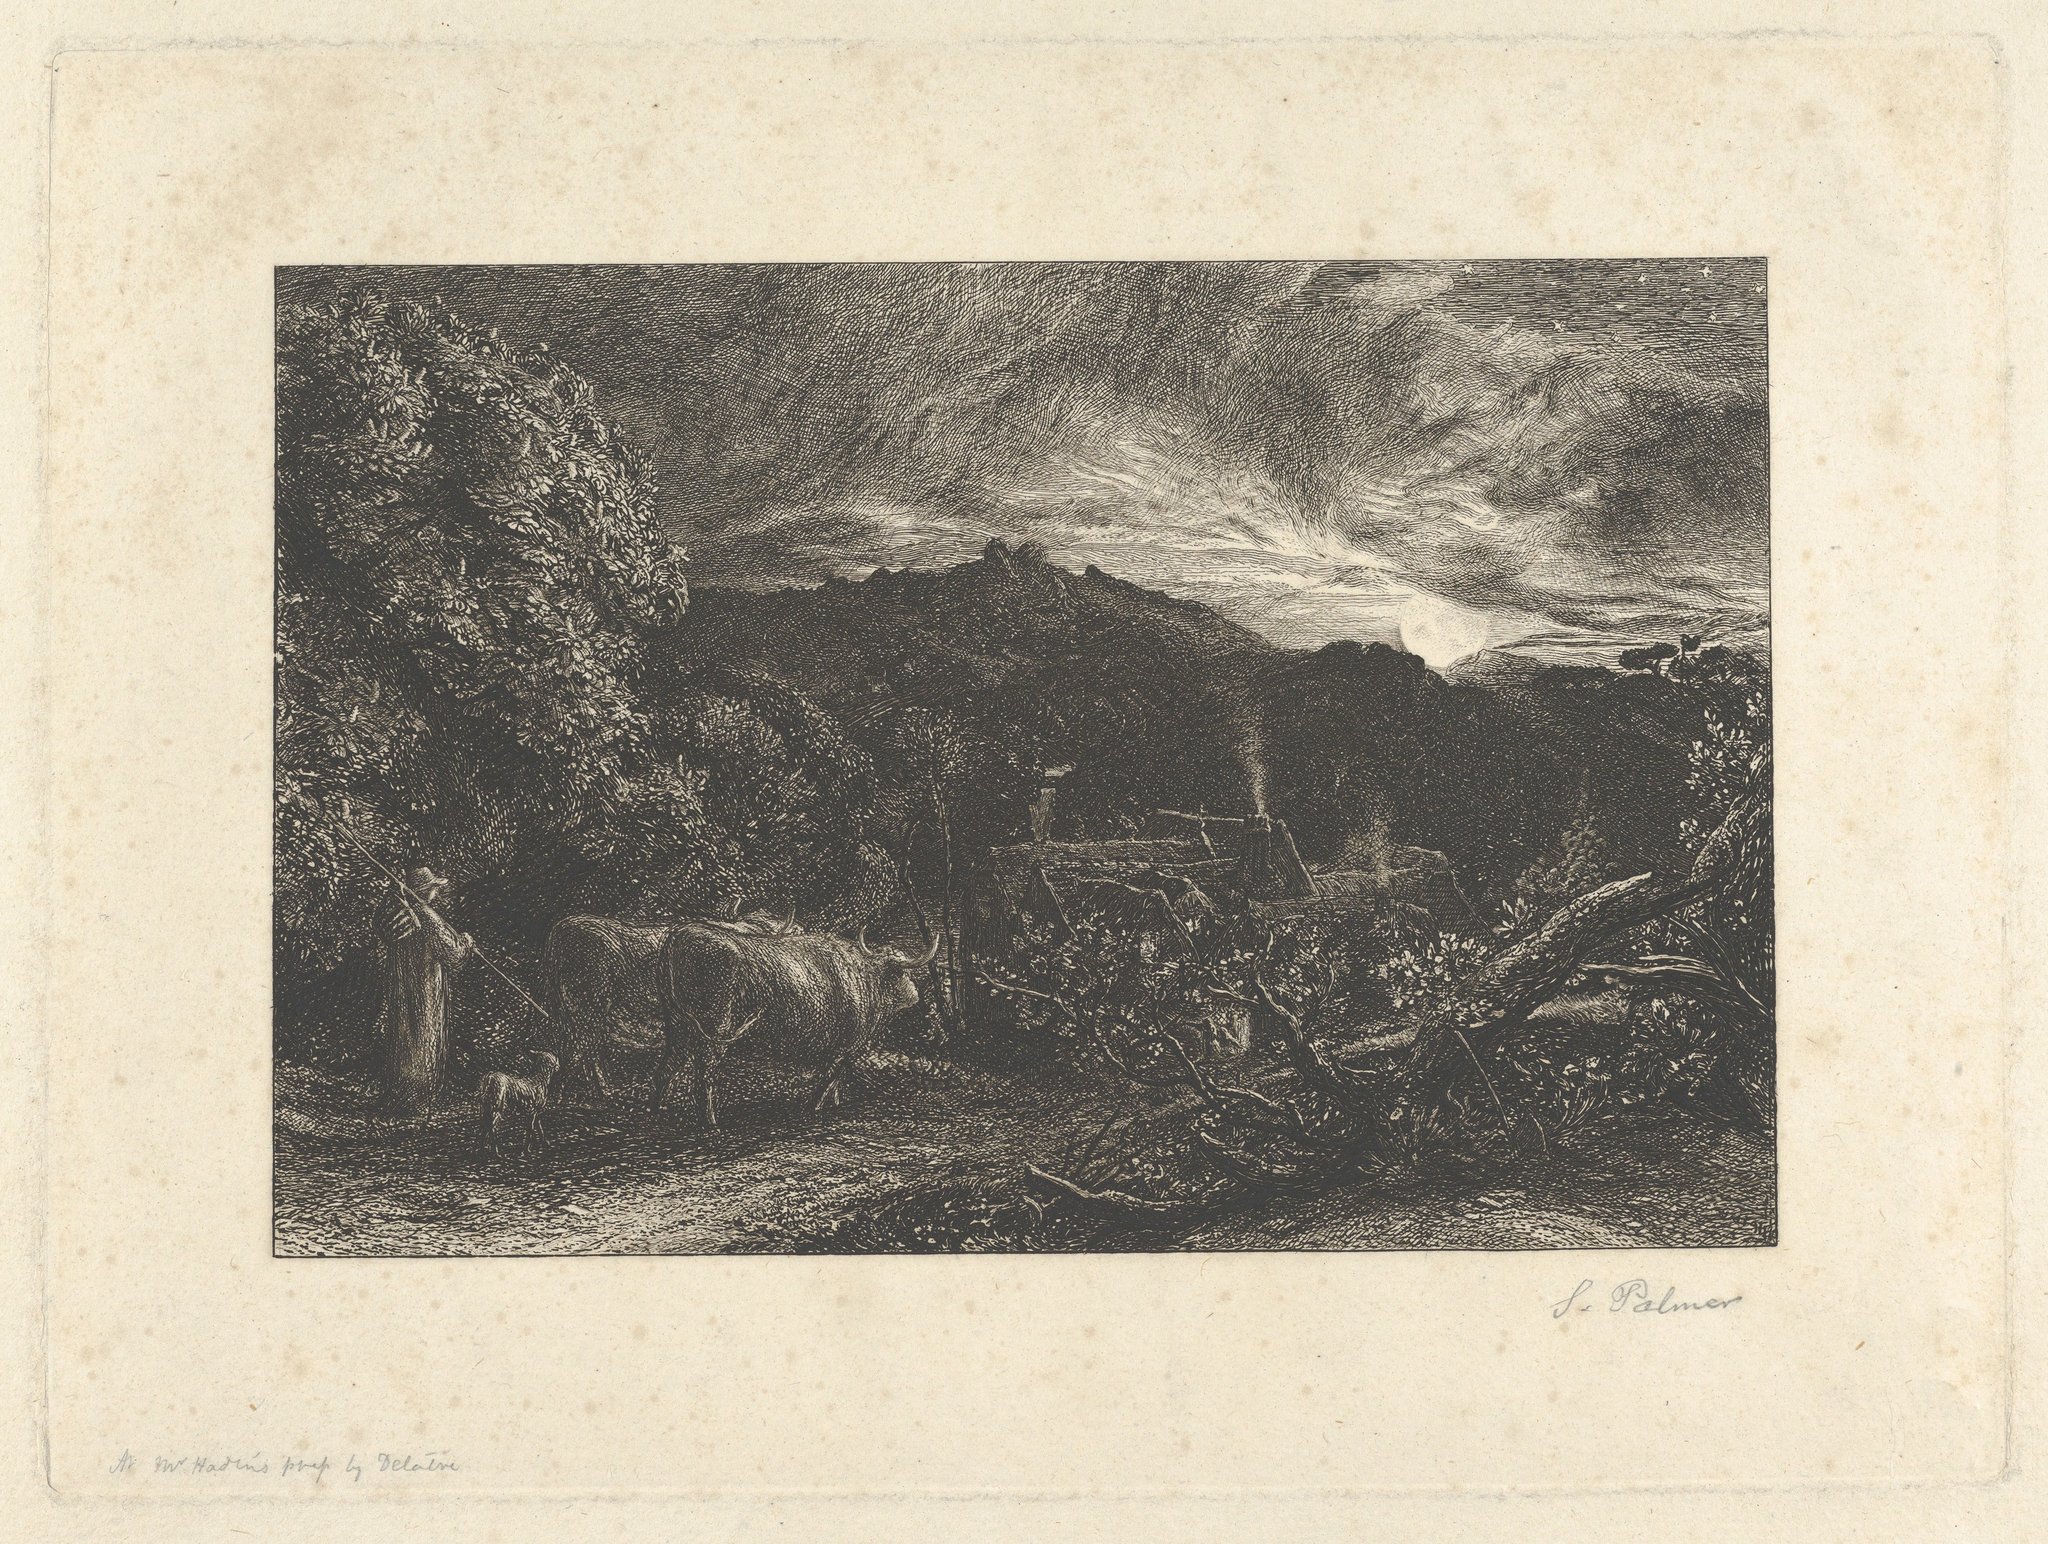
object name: print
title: The Weary Ploughman, or The Herdsman, or Tardus Bubulcus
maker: samuel palmer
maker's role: artist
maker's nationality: british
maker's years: 1805-1881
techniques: etching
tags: animals,men,trees